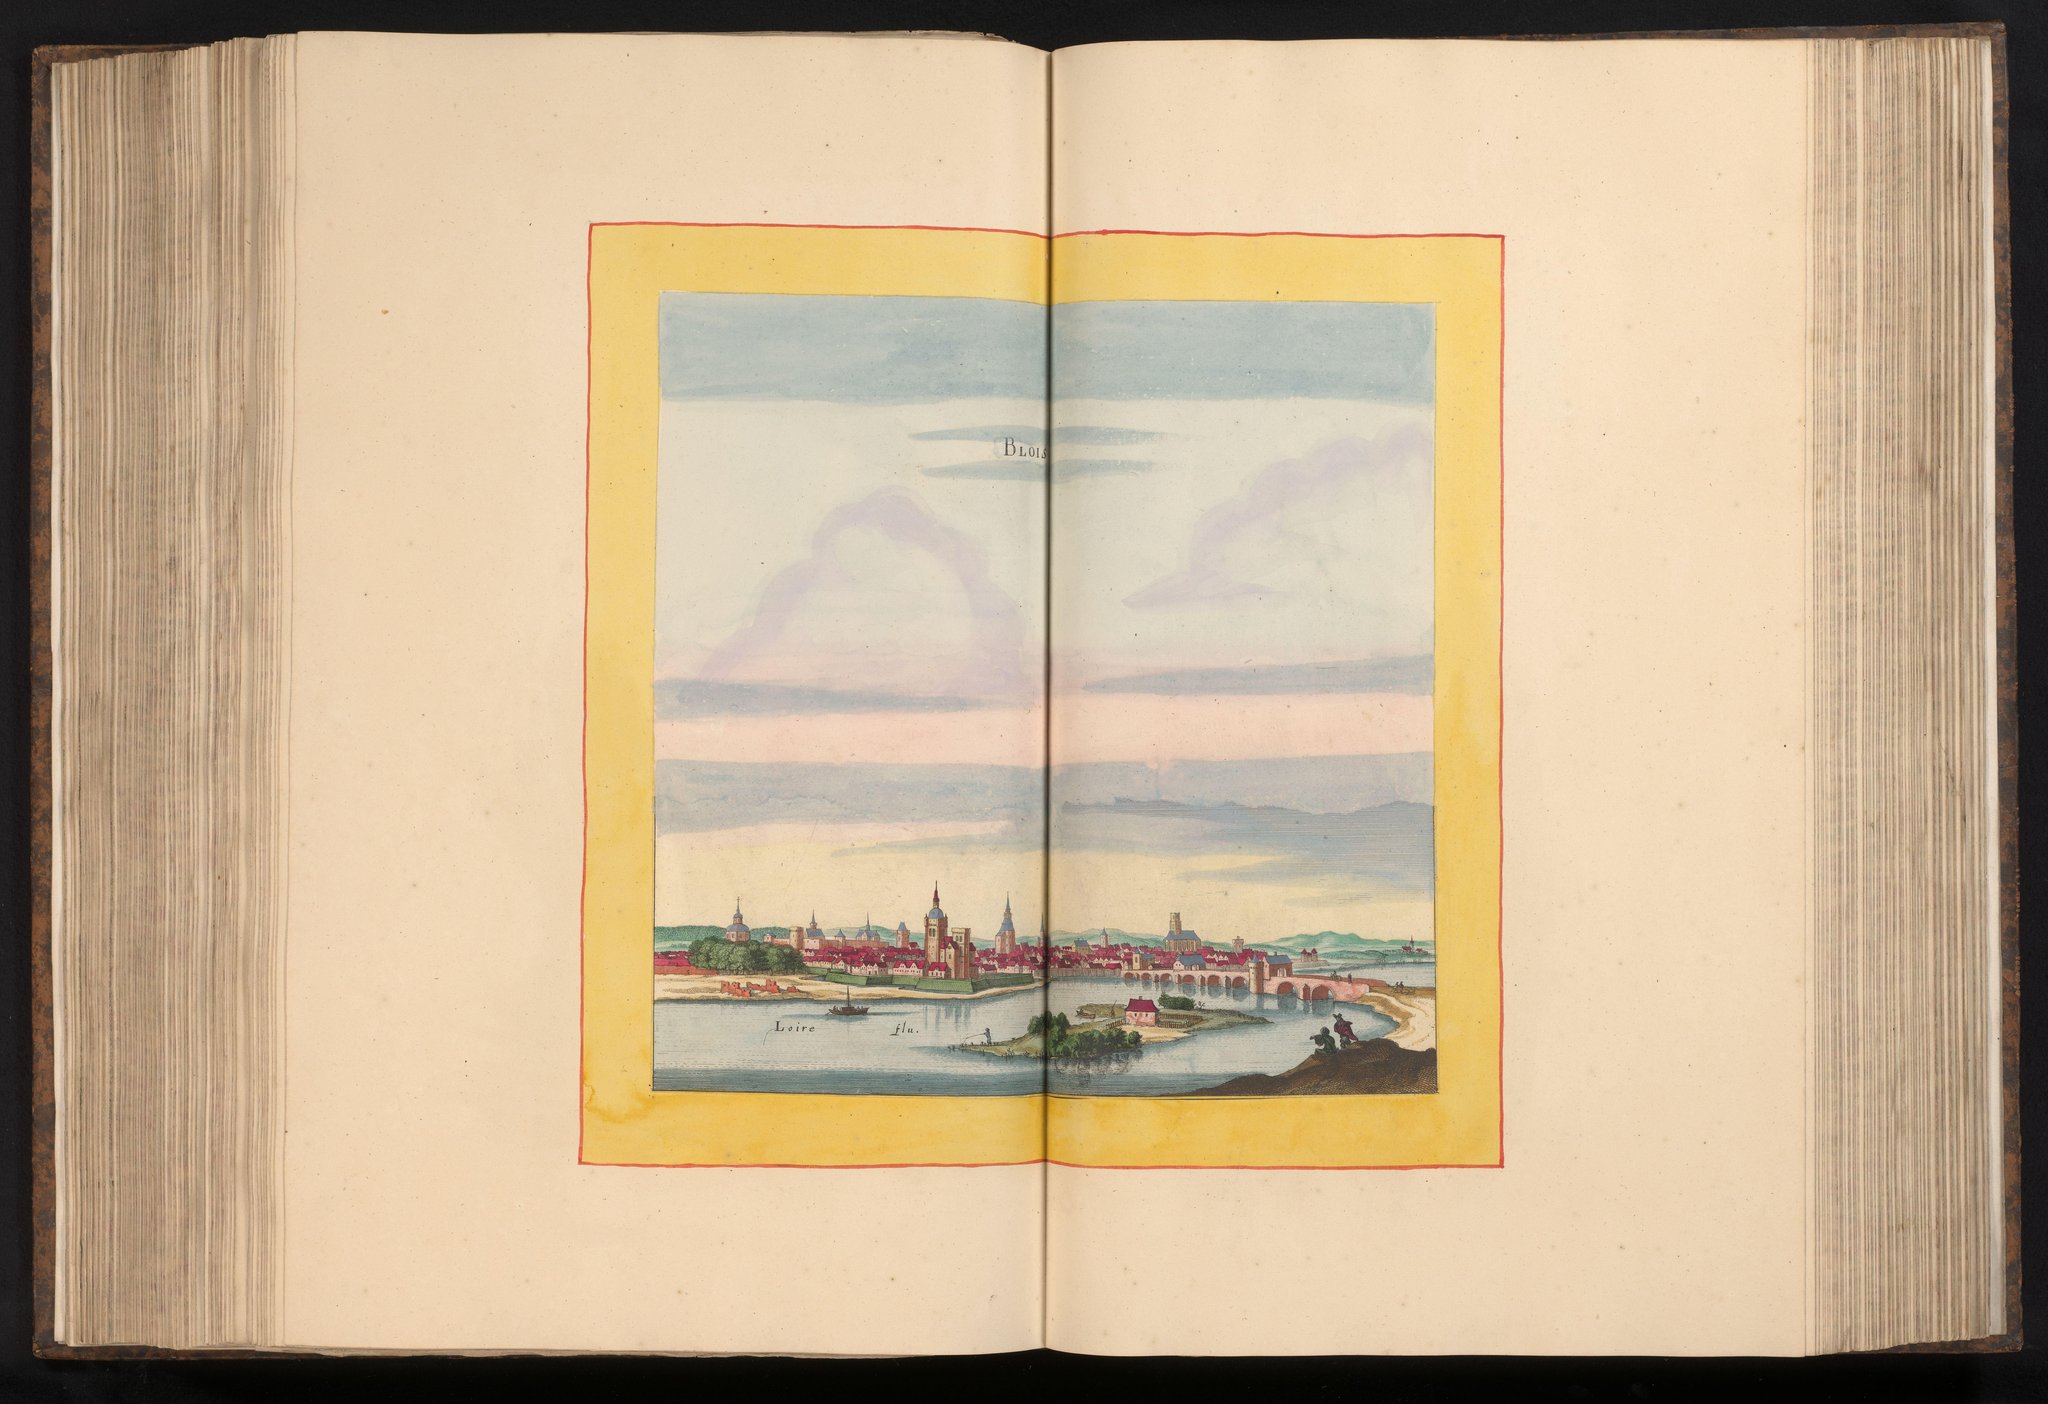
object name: album leaf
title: Gezicht op Blois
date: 1657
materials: paper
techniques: engraving, etching, hand coloring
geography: the hague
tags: city-view in general; 'veduta'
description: Prent uit: Zeiller, Martin. Topographia Galliae. 13 dln. Frankfurt: Caspar Merian, 1657, dl. 7, na p. 12. De titel is uit de originele prent gesneden. Boven de gravure is een deel lucht en wolken (bij)geschilderd, waarin de titel gelijmd is. Origineel op één blad gedrukt met het gezicht op Angoulême (RP-P-1956-181).